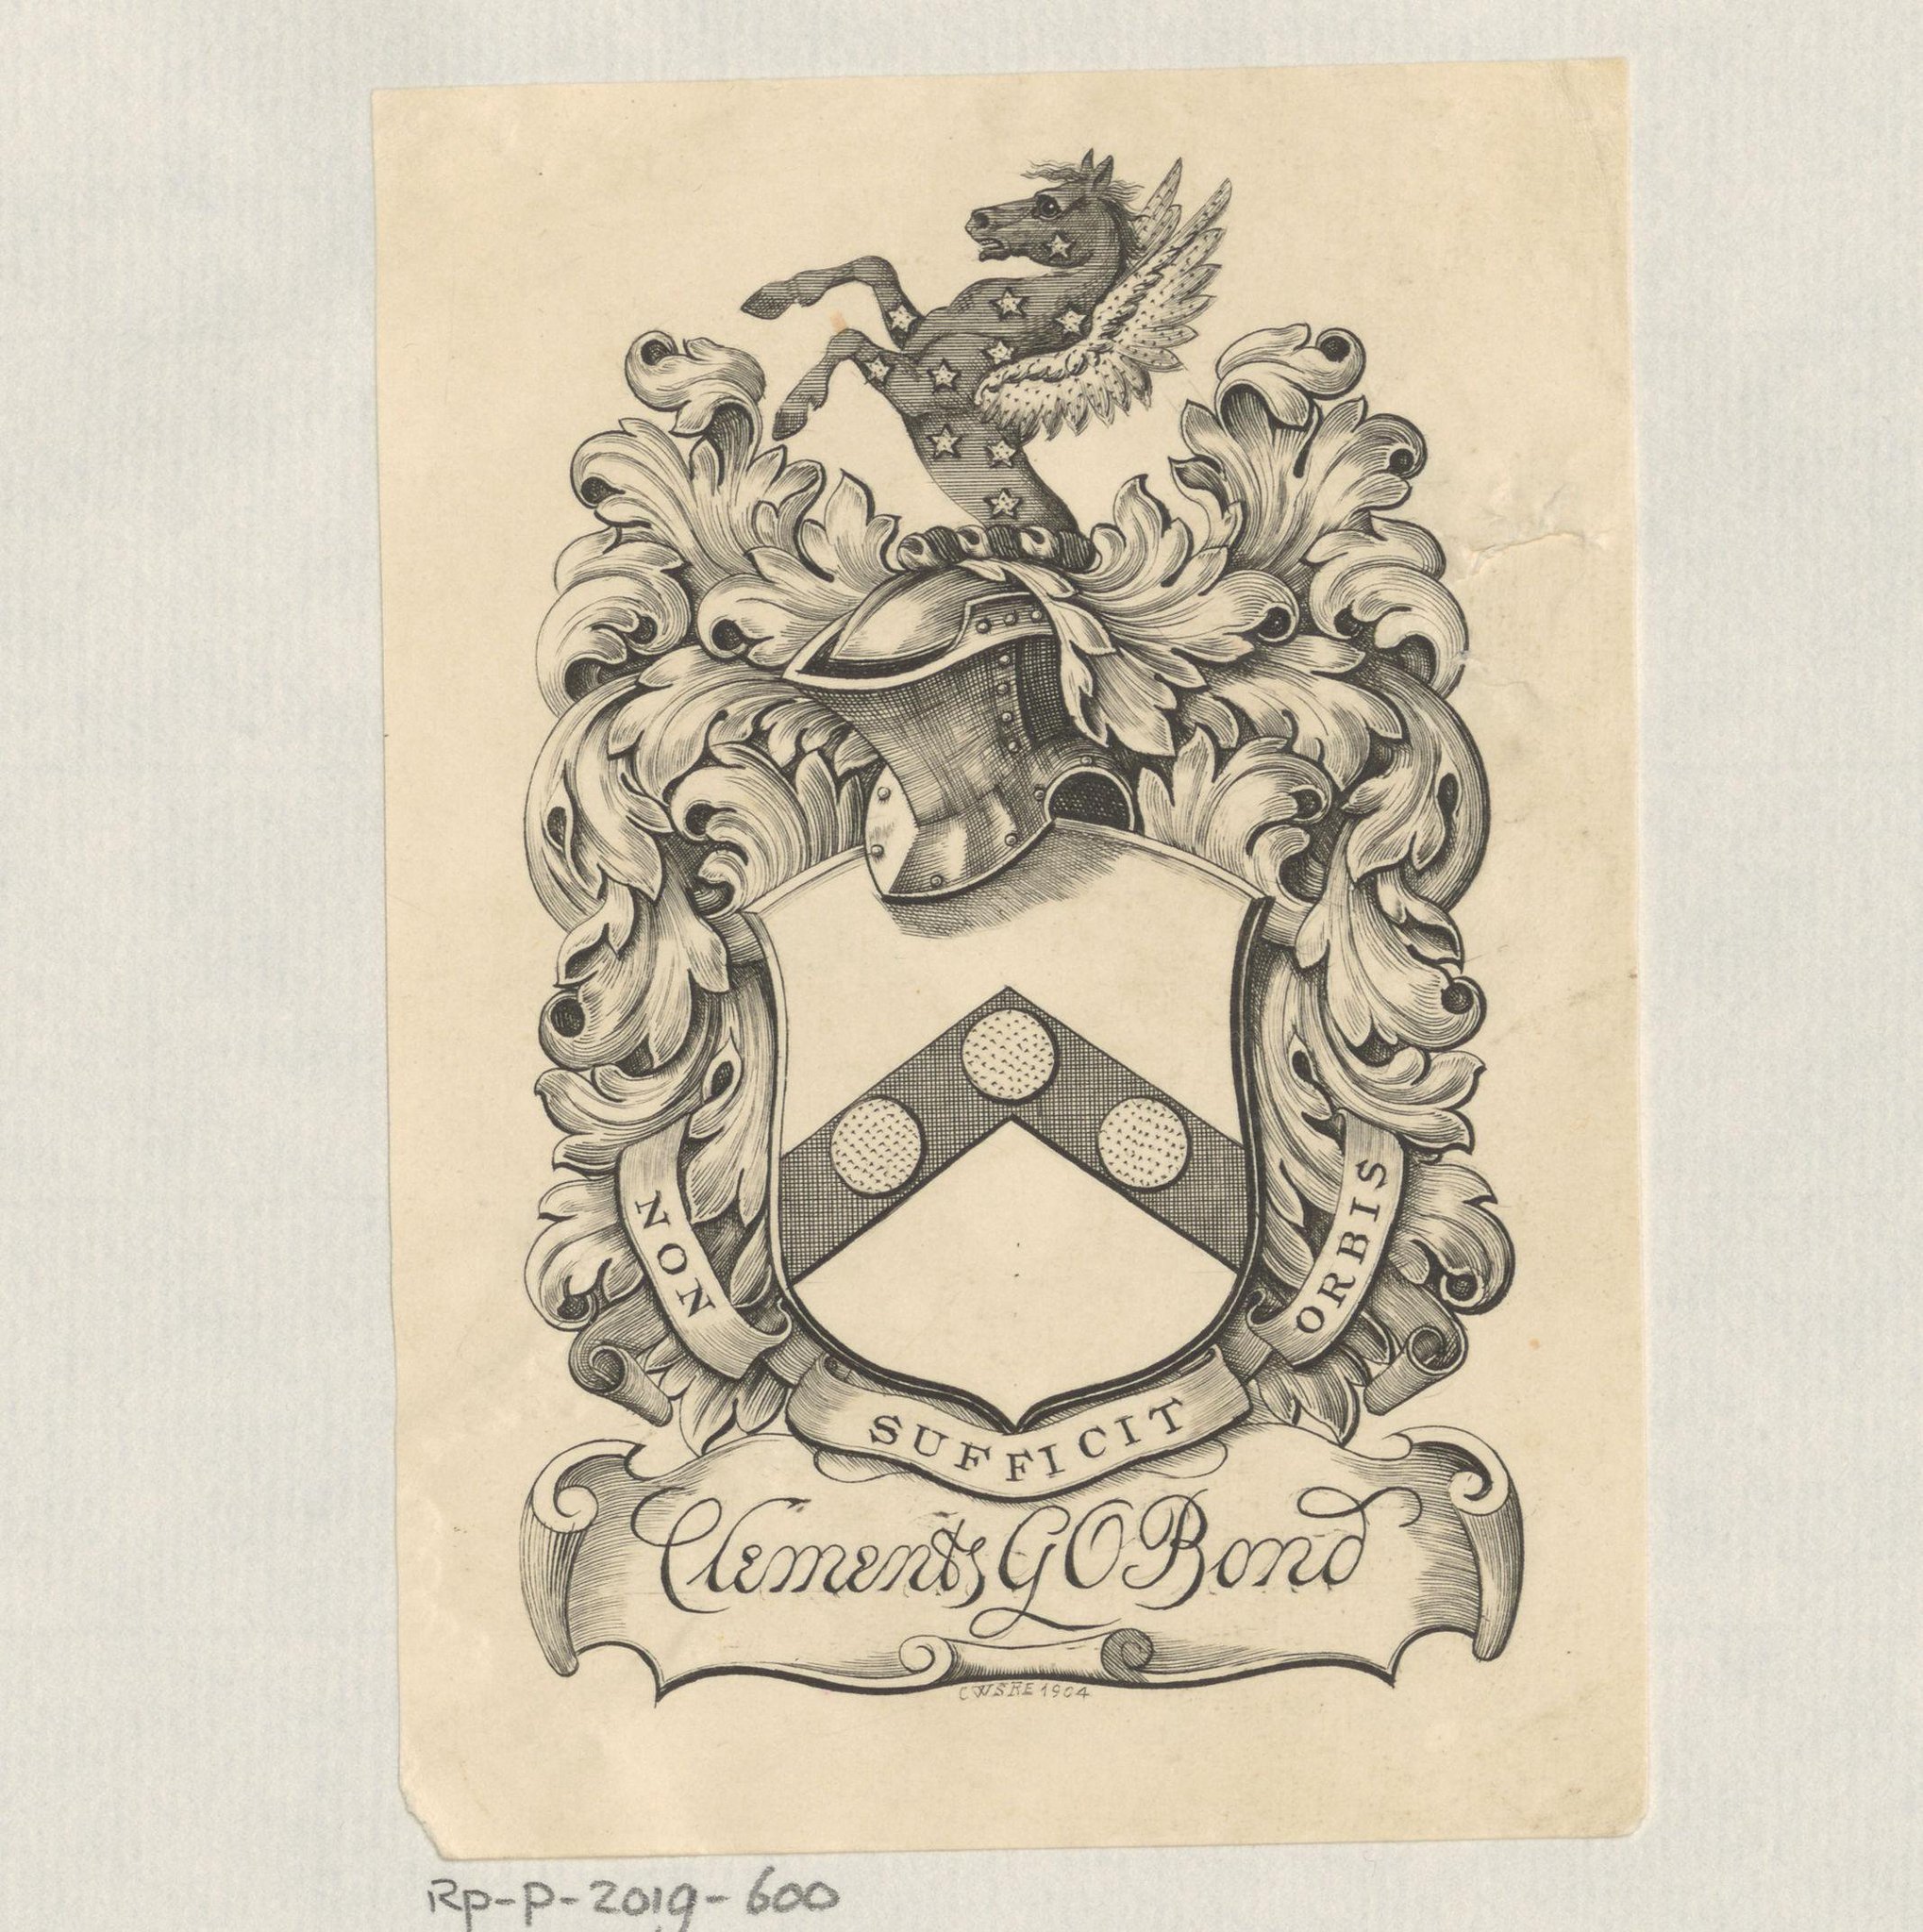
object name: bookplate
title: Non sufficit orbis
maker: charles william sherborn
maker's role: print maker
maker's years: 1831-1912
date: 1904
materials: paper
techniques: engraving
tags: study; 'studiolo'; library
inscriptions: date